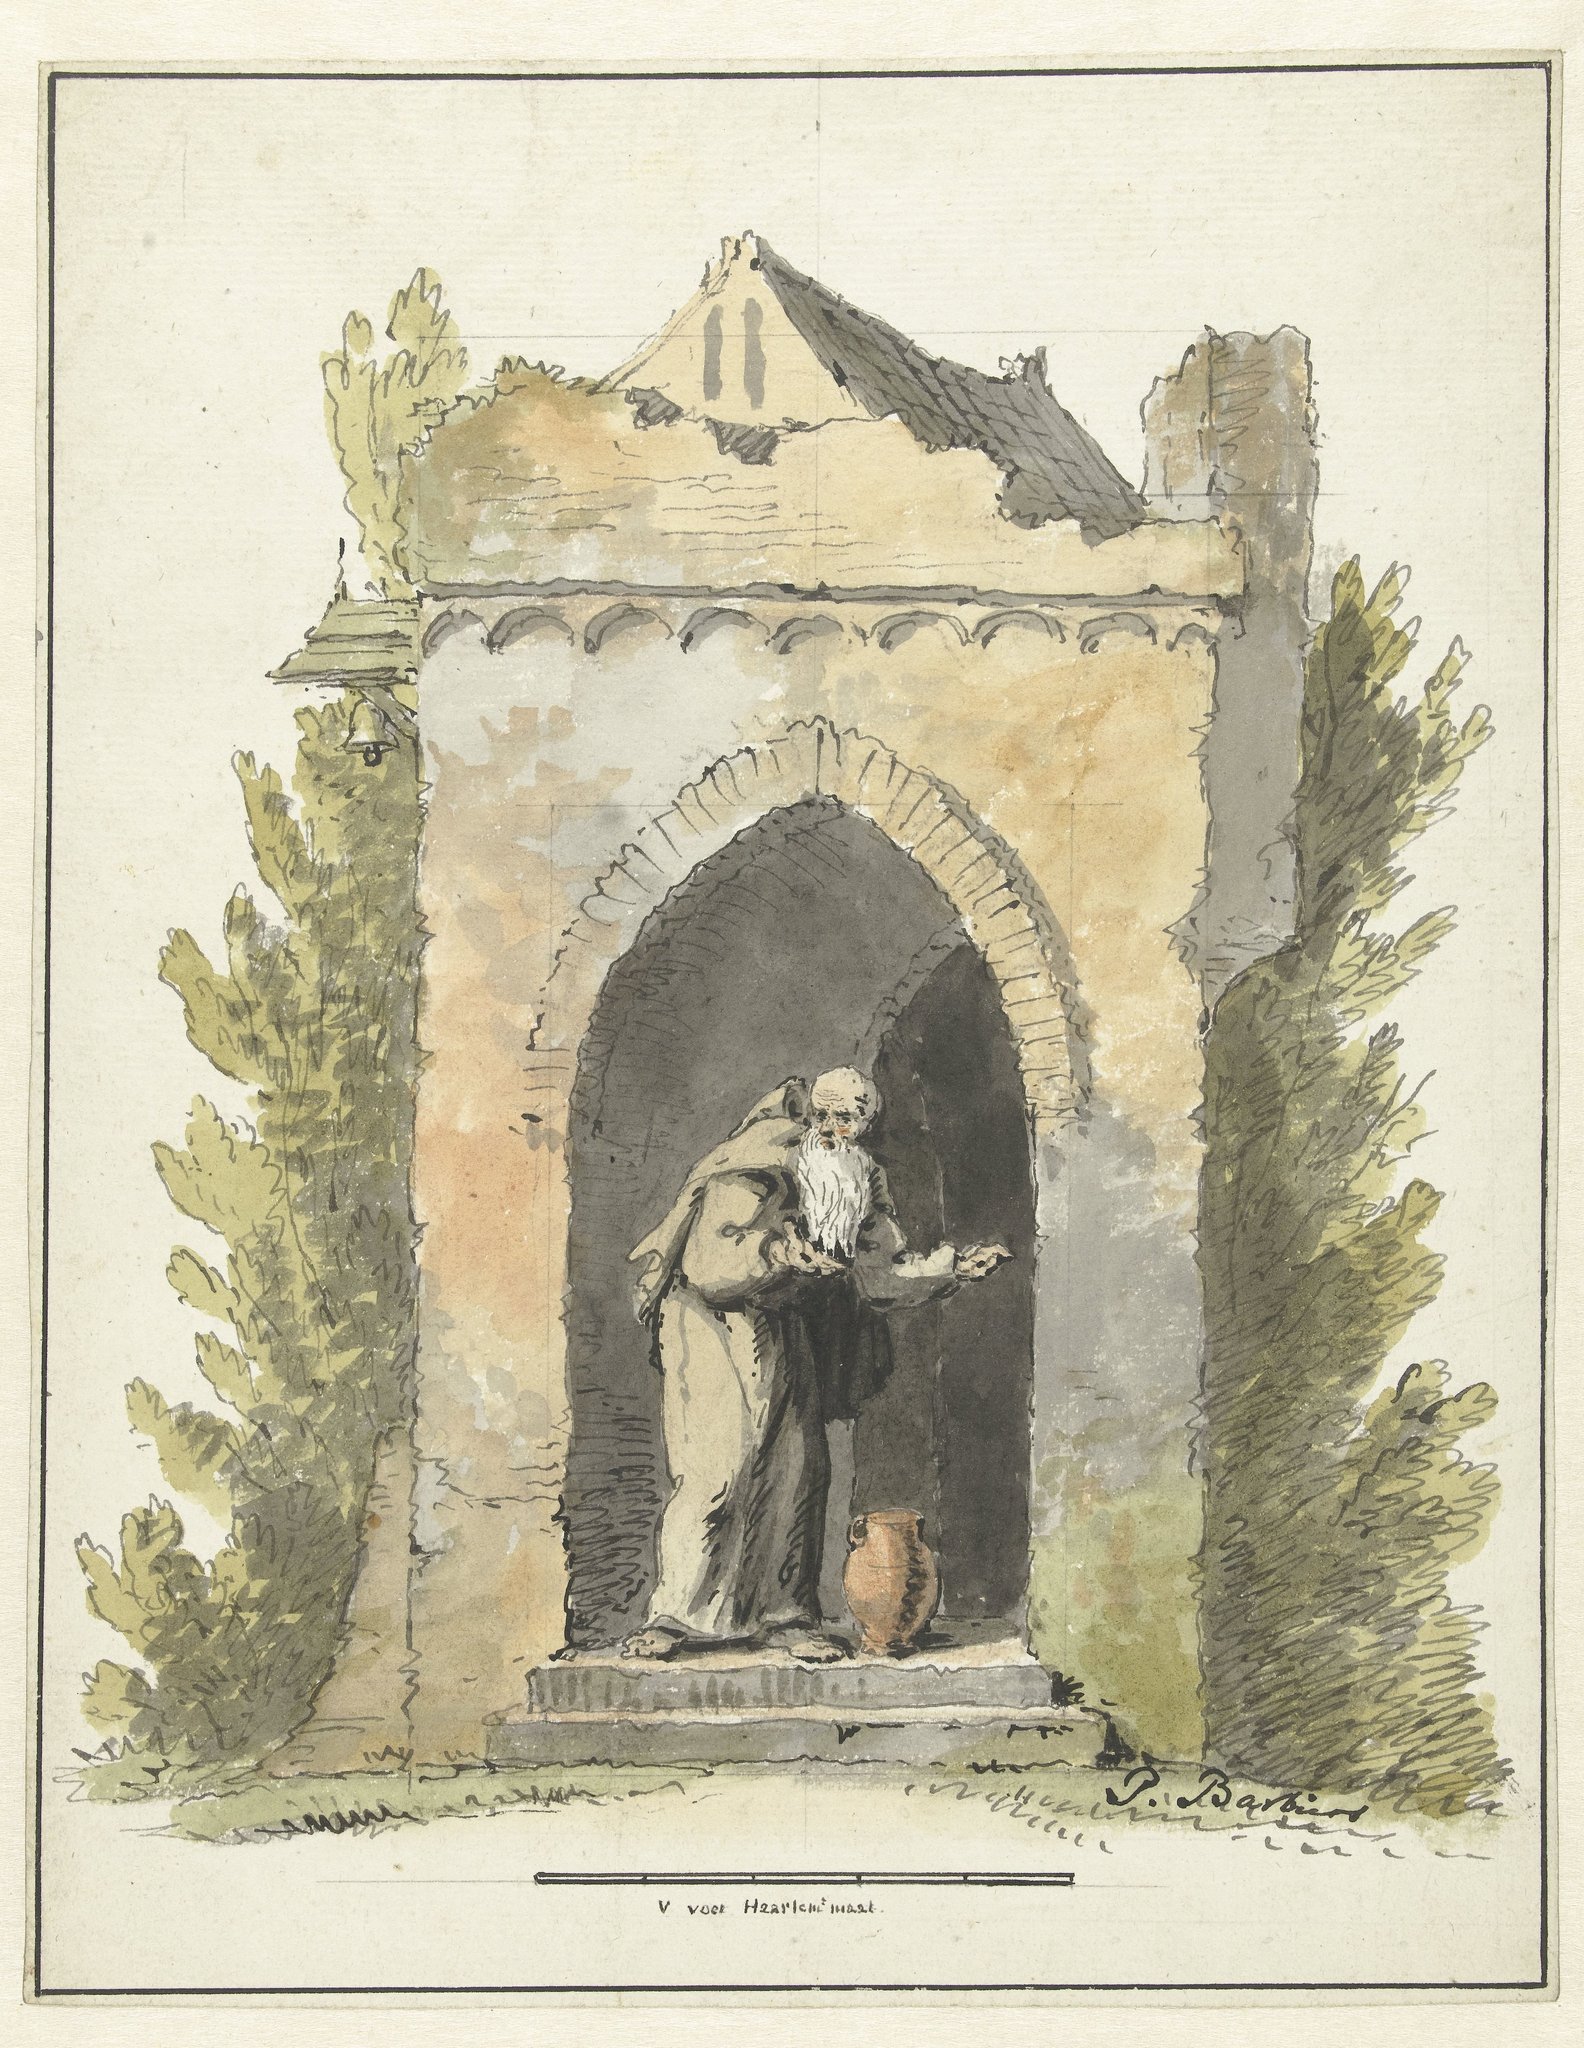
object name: watercolor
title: Kluizenaar voor een stenen kapel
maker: pieter bartholomeusz. barbiers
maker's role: draughtsman, print maker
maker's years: 1772-1837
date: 1782-1837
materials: graphite, ink, paper, watercolor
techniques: brush, pen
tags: hermitage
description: Kluizenaar voor een stenen kapel; ontwerp voor een tuindecoratie.